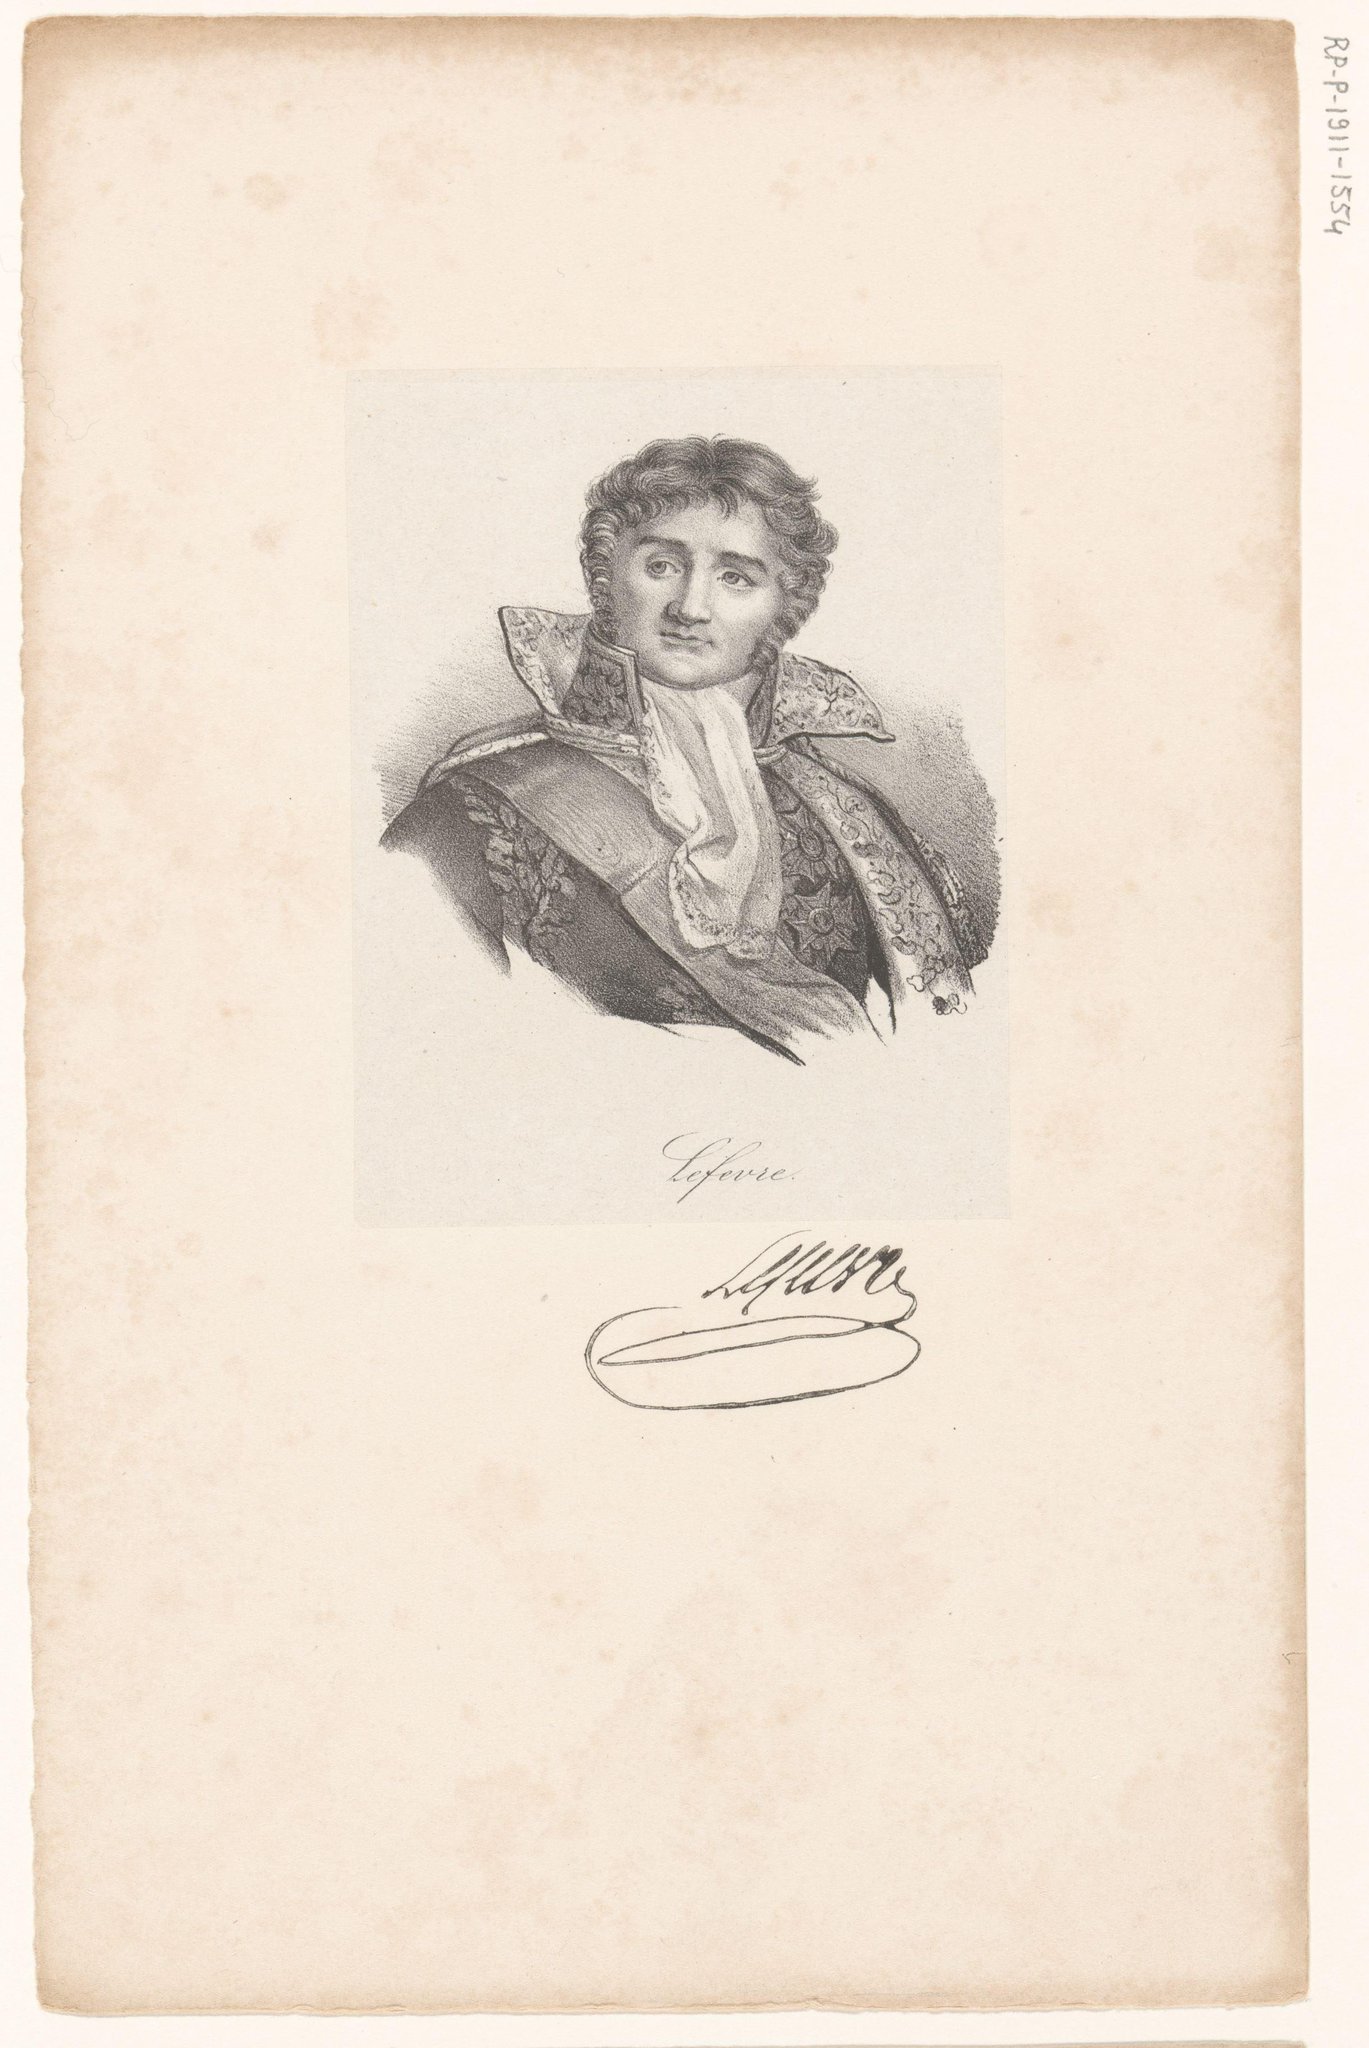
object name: print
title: Lefèvre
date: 1818-1842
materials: paper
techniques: lithograph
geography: paris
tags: historical persons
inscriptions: collector's mark: Lugt 2228a